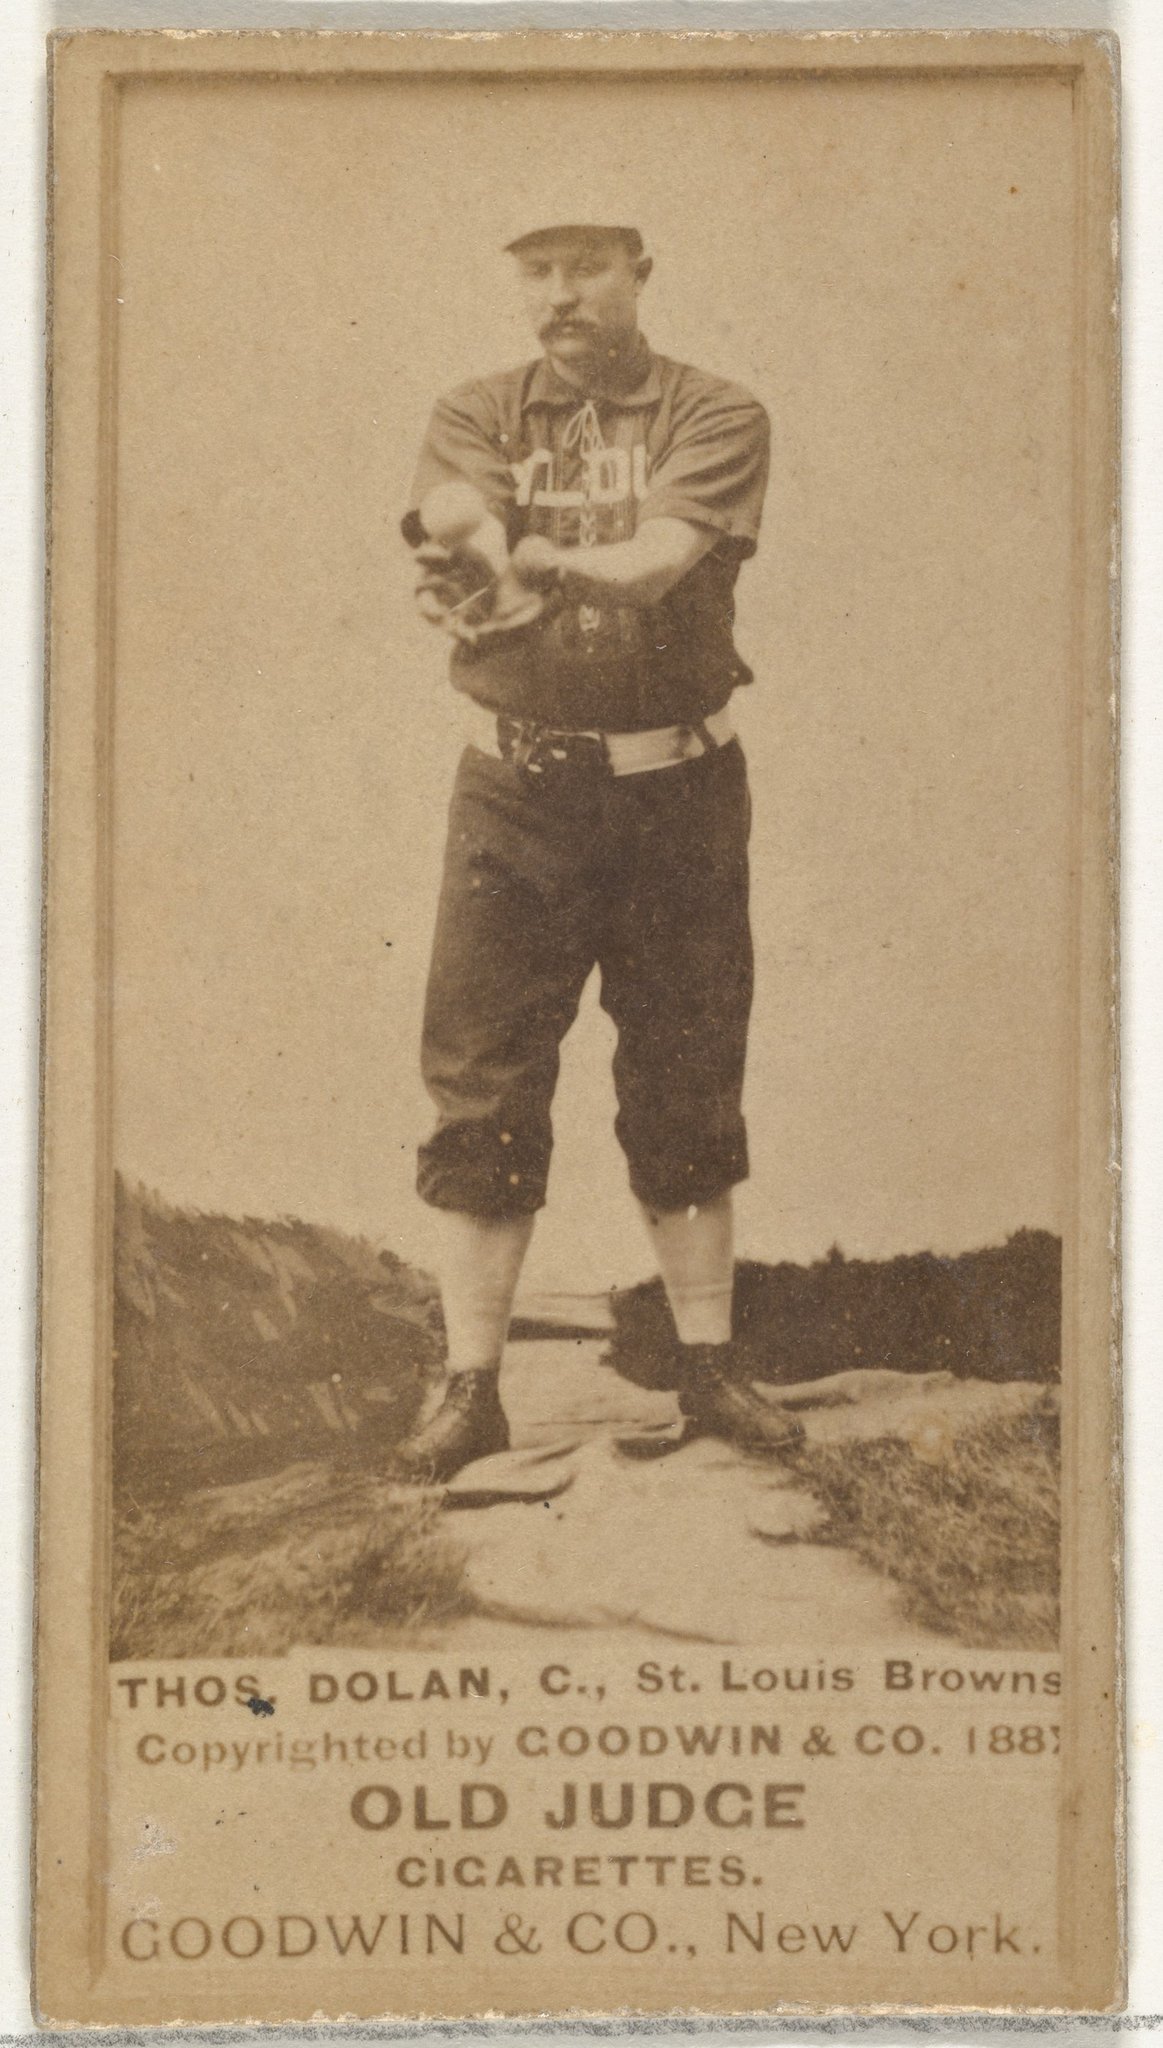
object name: baseball card, photograph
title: Thomas J. "Tom" Dolan, Catcher, St. Louis Browns, from the Old Judge series (N172) for Old Judge Cigarettes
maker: goodwin & company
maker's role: publisher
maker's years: 1850-1950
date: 1887-1889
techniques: albumen silver print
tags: men,portraits,baseball,athletes